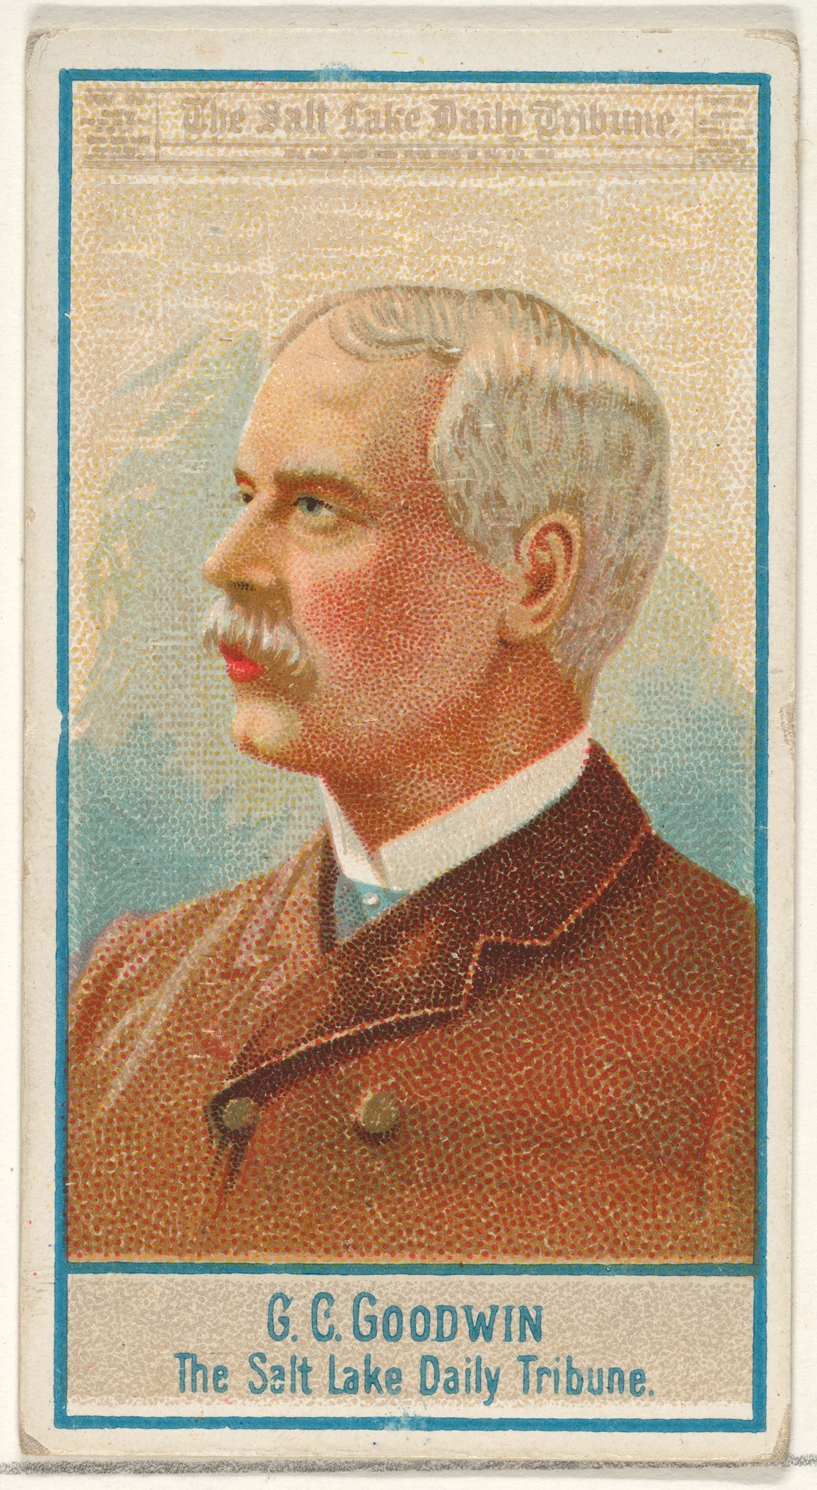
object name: print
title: G.C. Goodwin, The Salt Lake City Tribune, from the American Editors series (N1) for Allen & Ginter Cigarettes Brands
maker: allen & ginter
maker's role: publisher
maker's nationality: american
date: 1887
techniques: color lithograph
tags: men